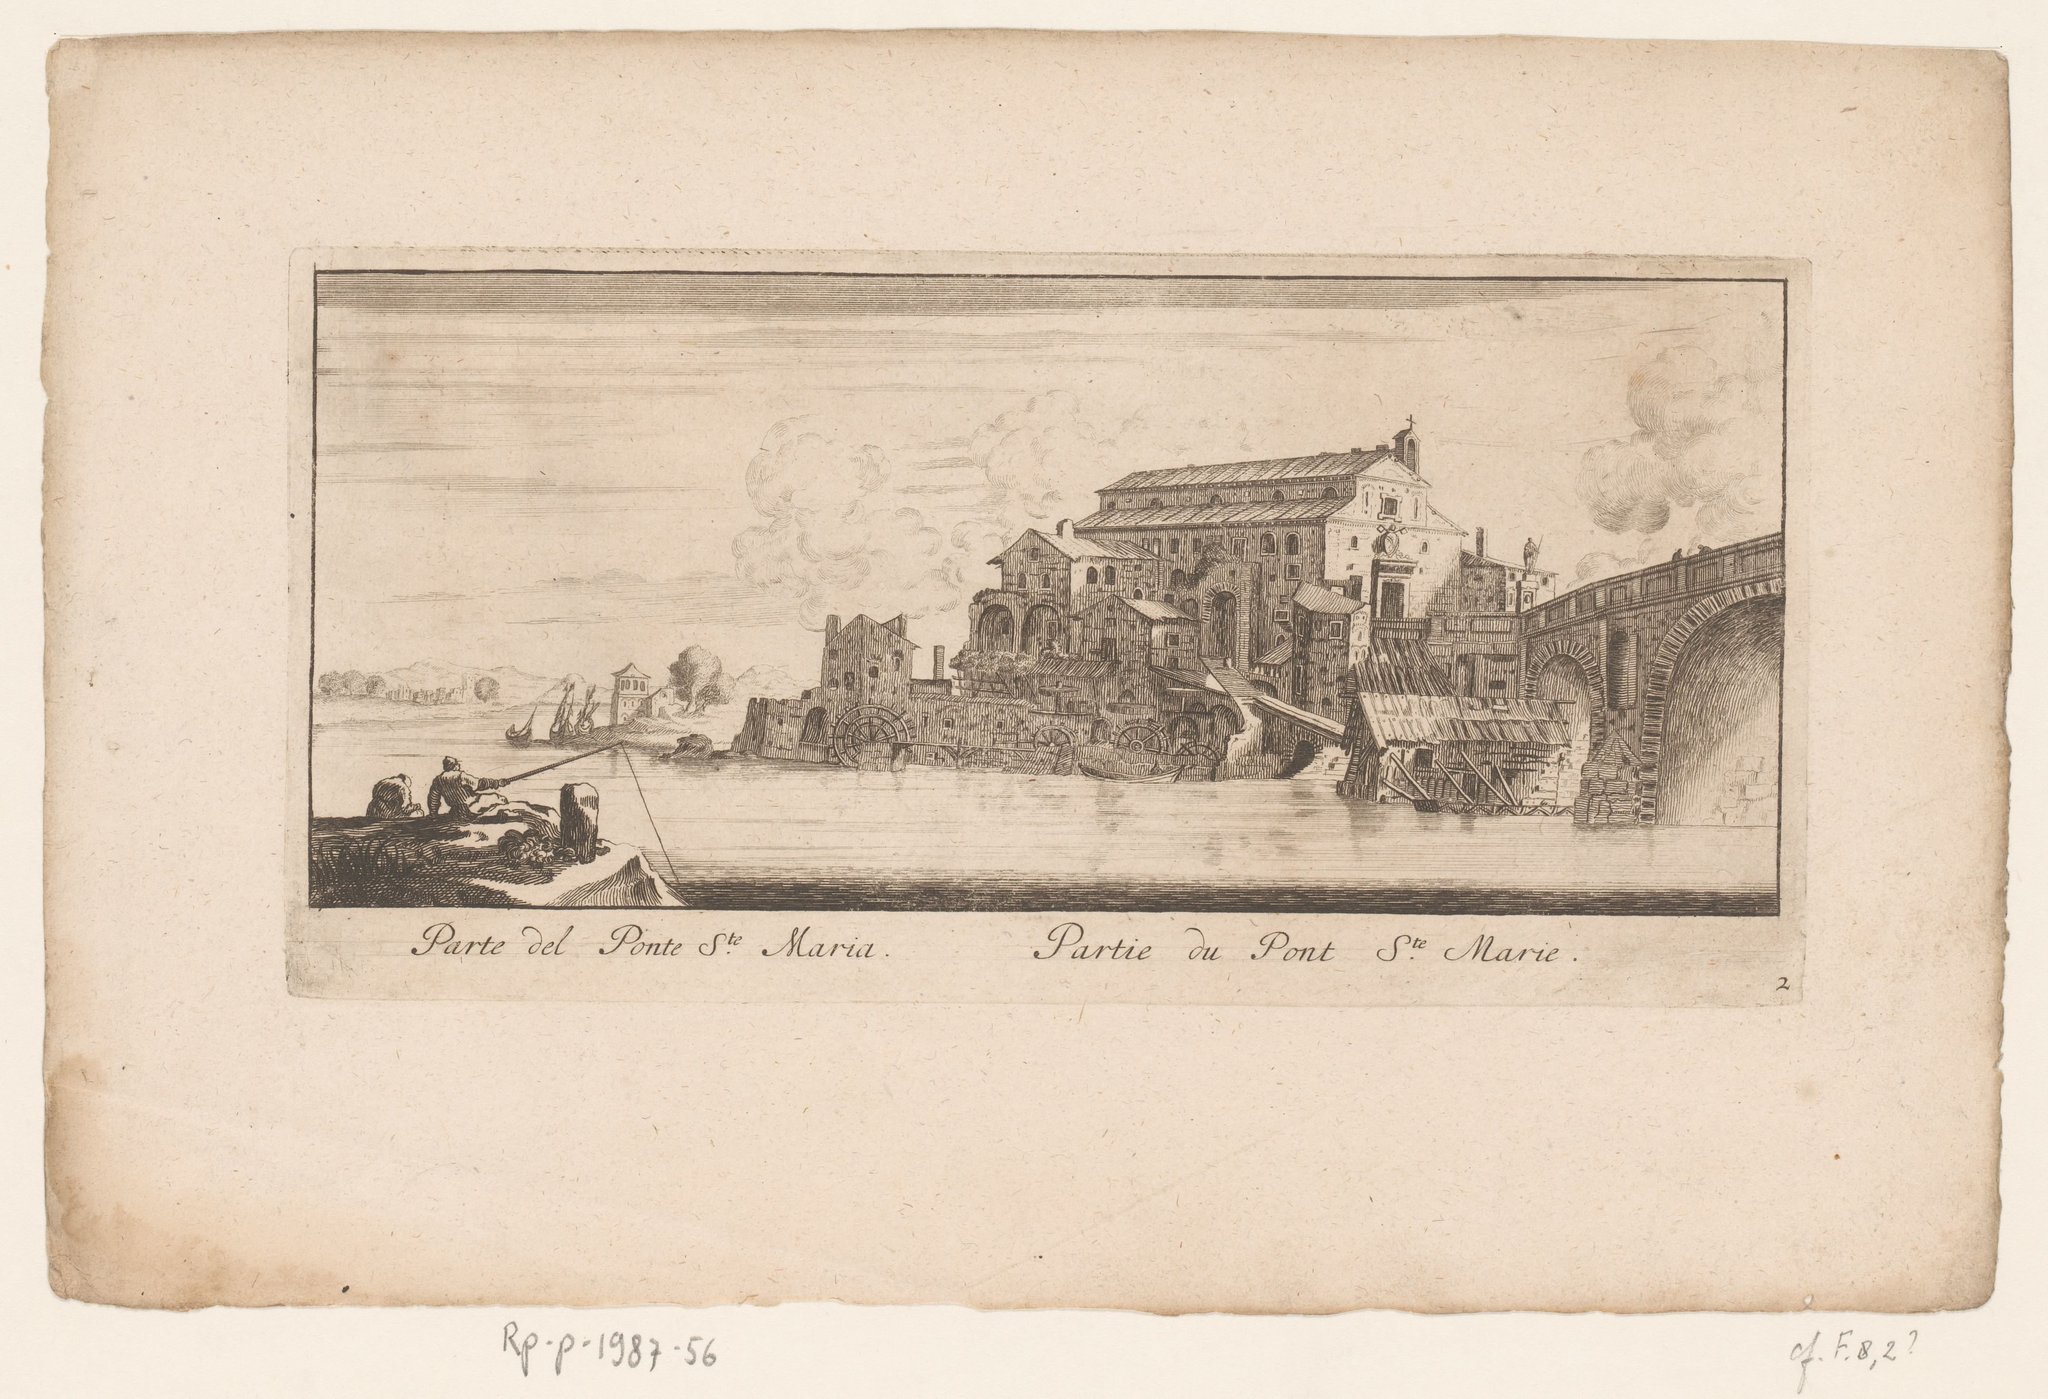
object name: print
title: Gezicht op een deel van de Ponte Rotto, te Rome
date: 1648-1712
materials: paper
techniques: engraving, etching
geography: amsterdam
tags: bridge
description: De brug werd voorheen Pons Aemilius en Pons Sancte Marie genoemd. Rechtsonder genummerd: 2.